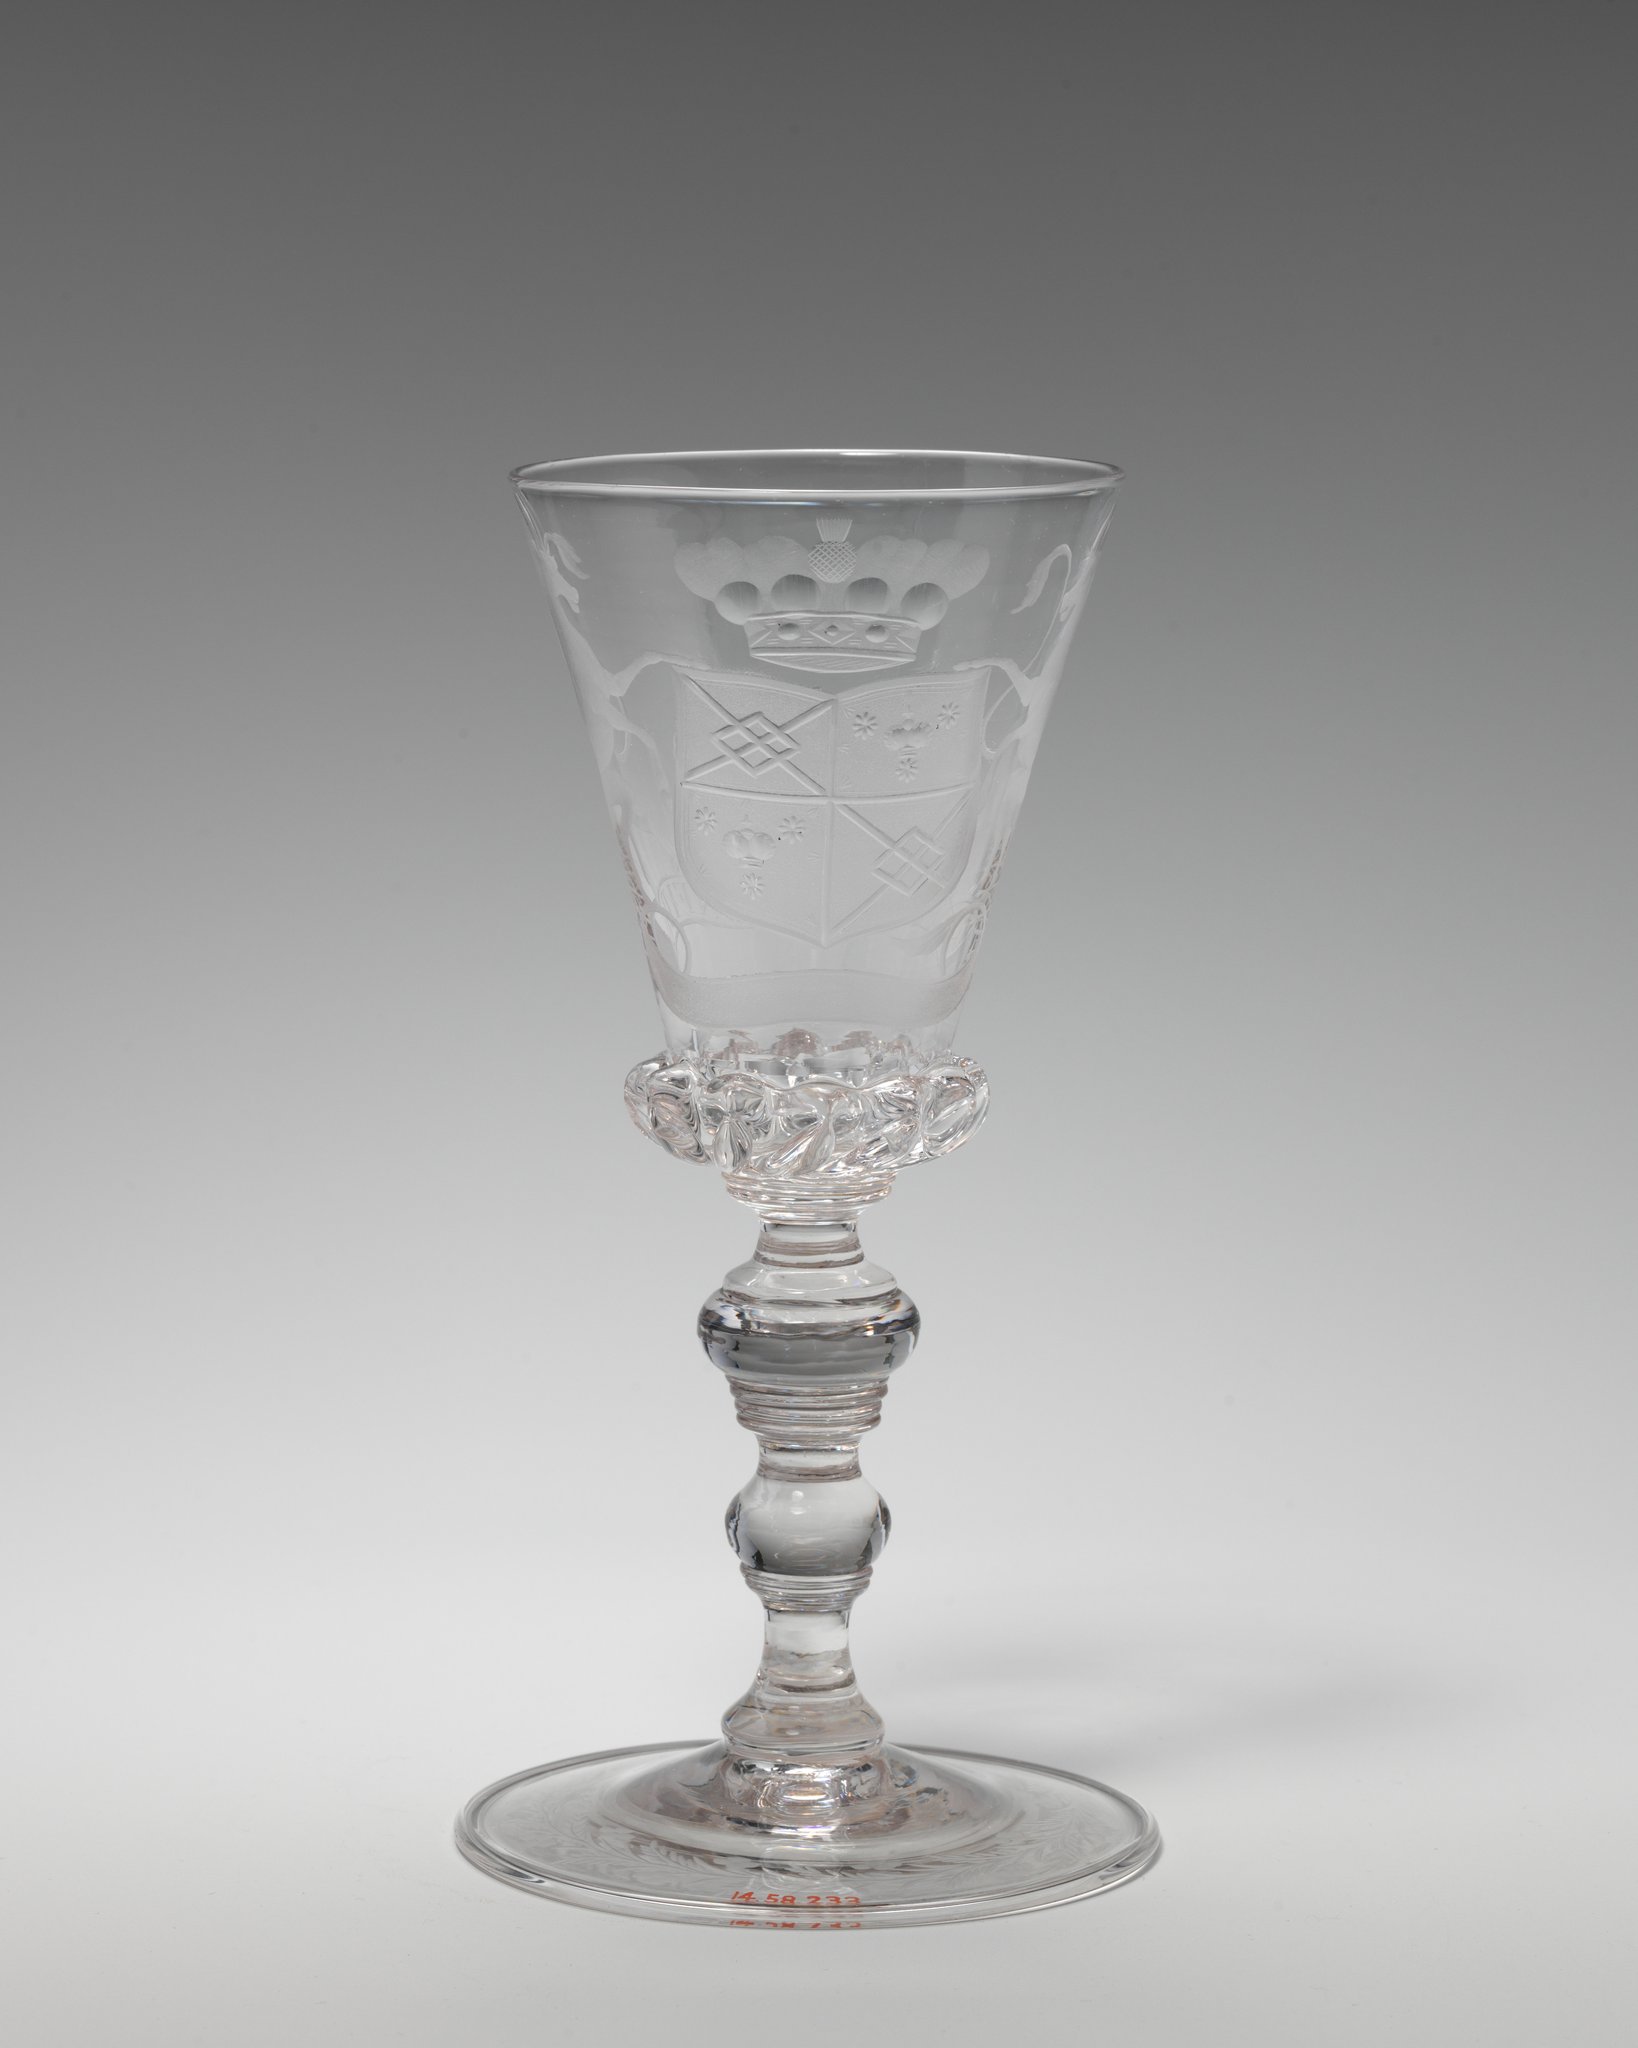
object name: wineglass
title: Wineglass (one of a pair)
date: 1867-1900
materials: glass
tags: coat of arms